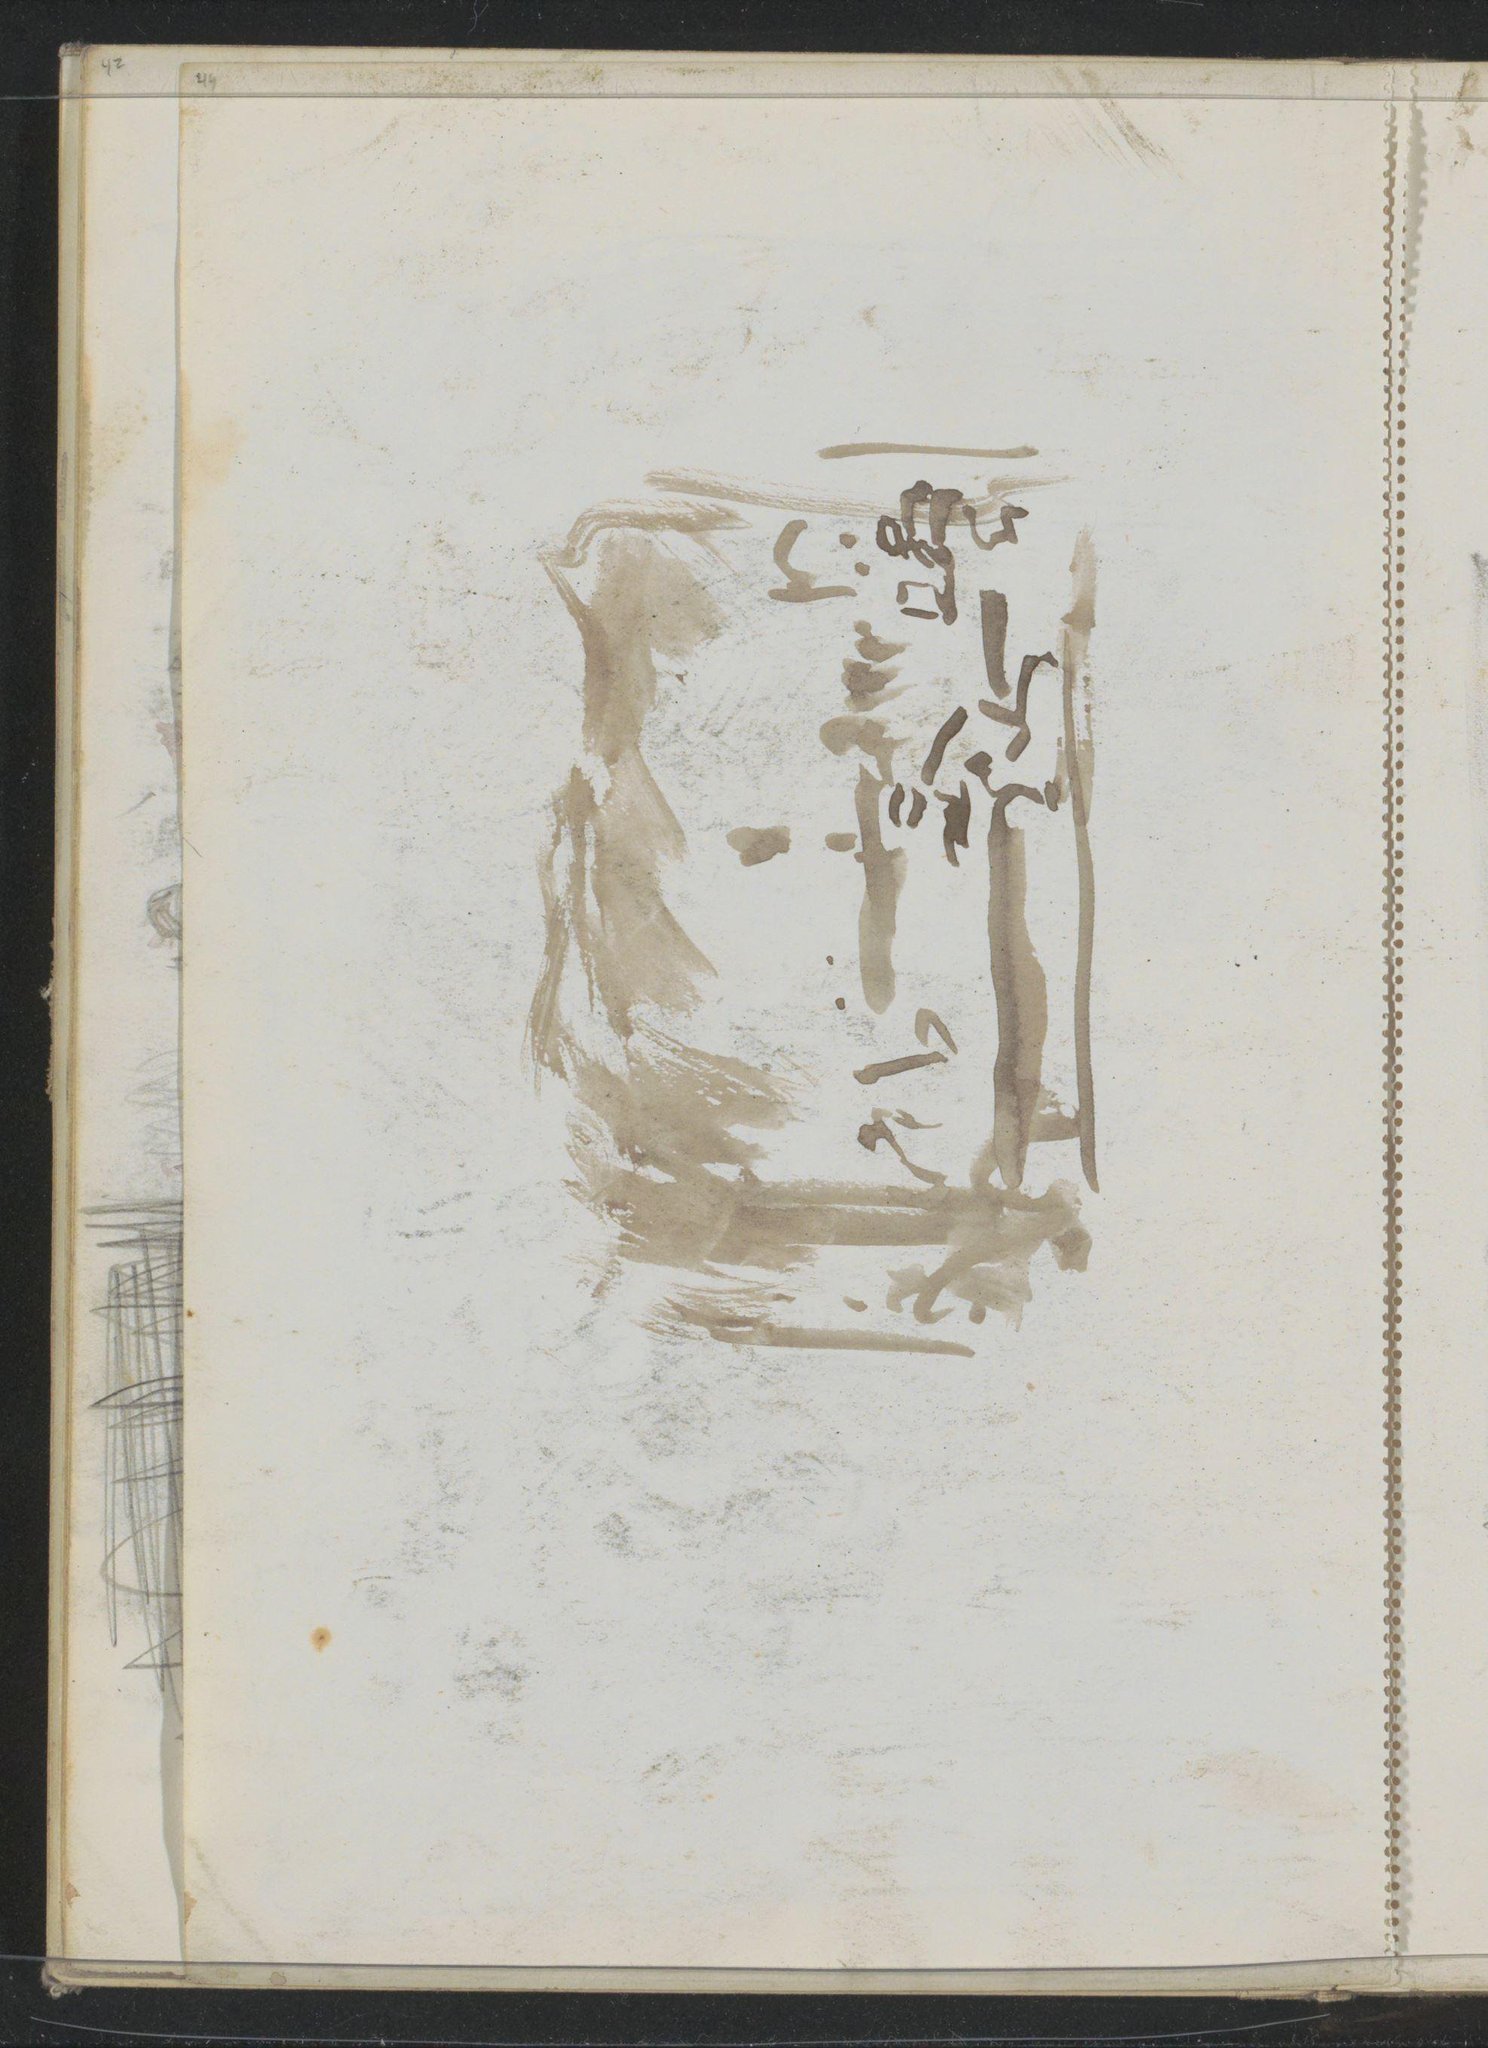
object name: sketchbook leaf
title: Figuren op een podium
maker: marius bauer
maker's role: draughtsman, print maker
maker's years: 1867-1932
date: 1925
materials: ink, paper, pencil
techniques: brush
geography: indonesia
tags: set, scenery ~ stage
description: Pagina 44 uit een schetsboek met 74 bladen.